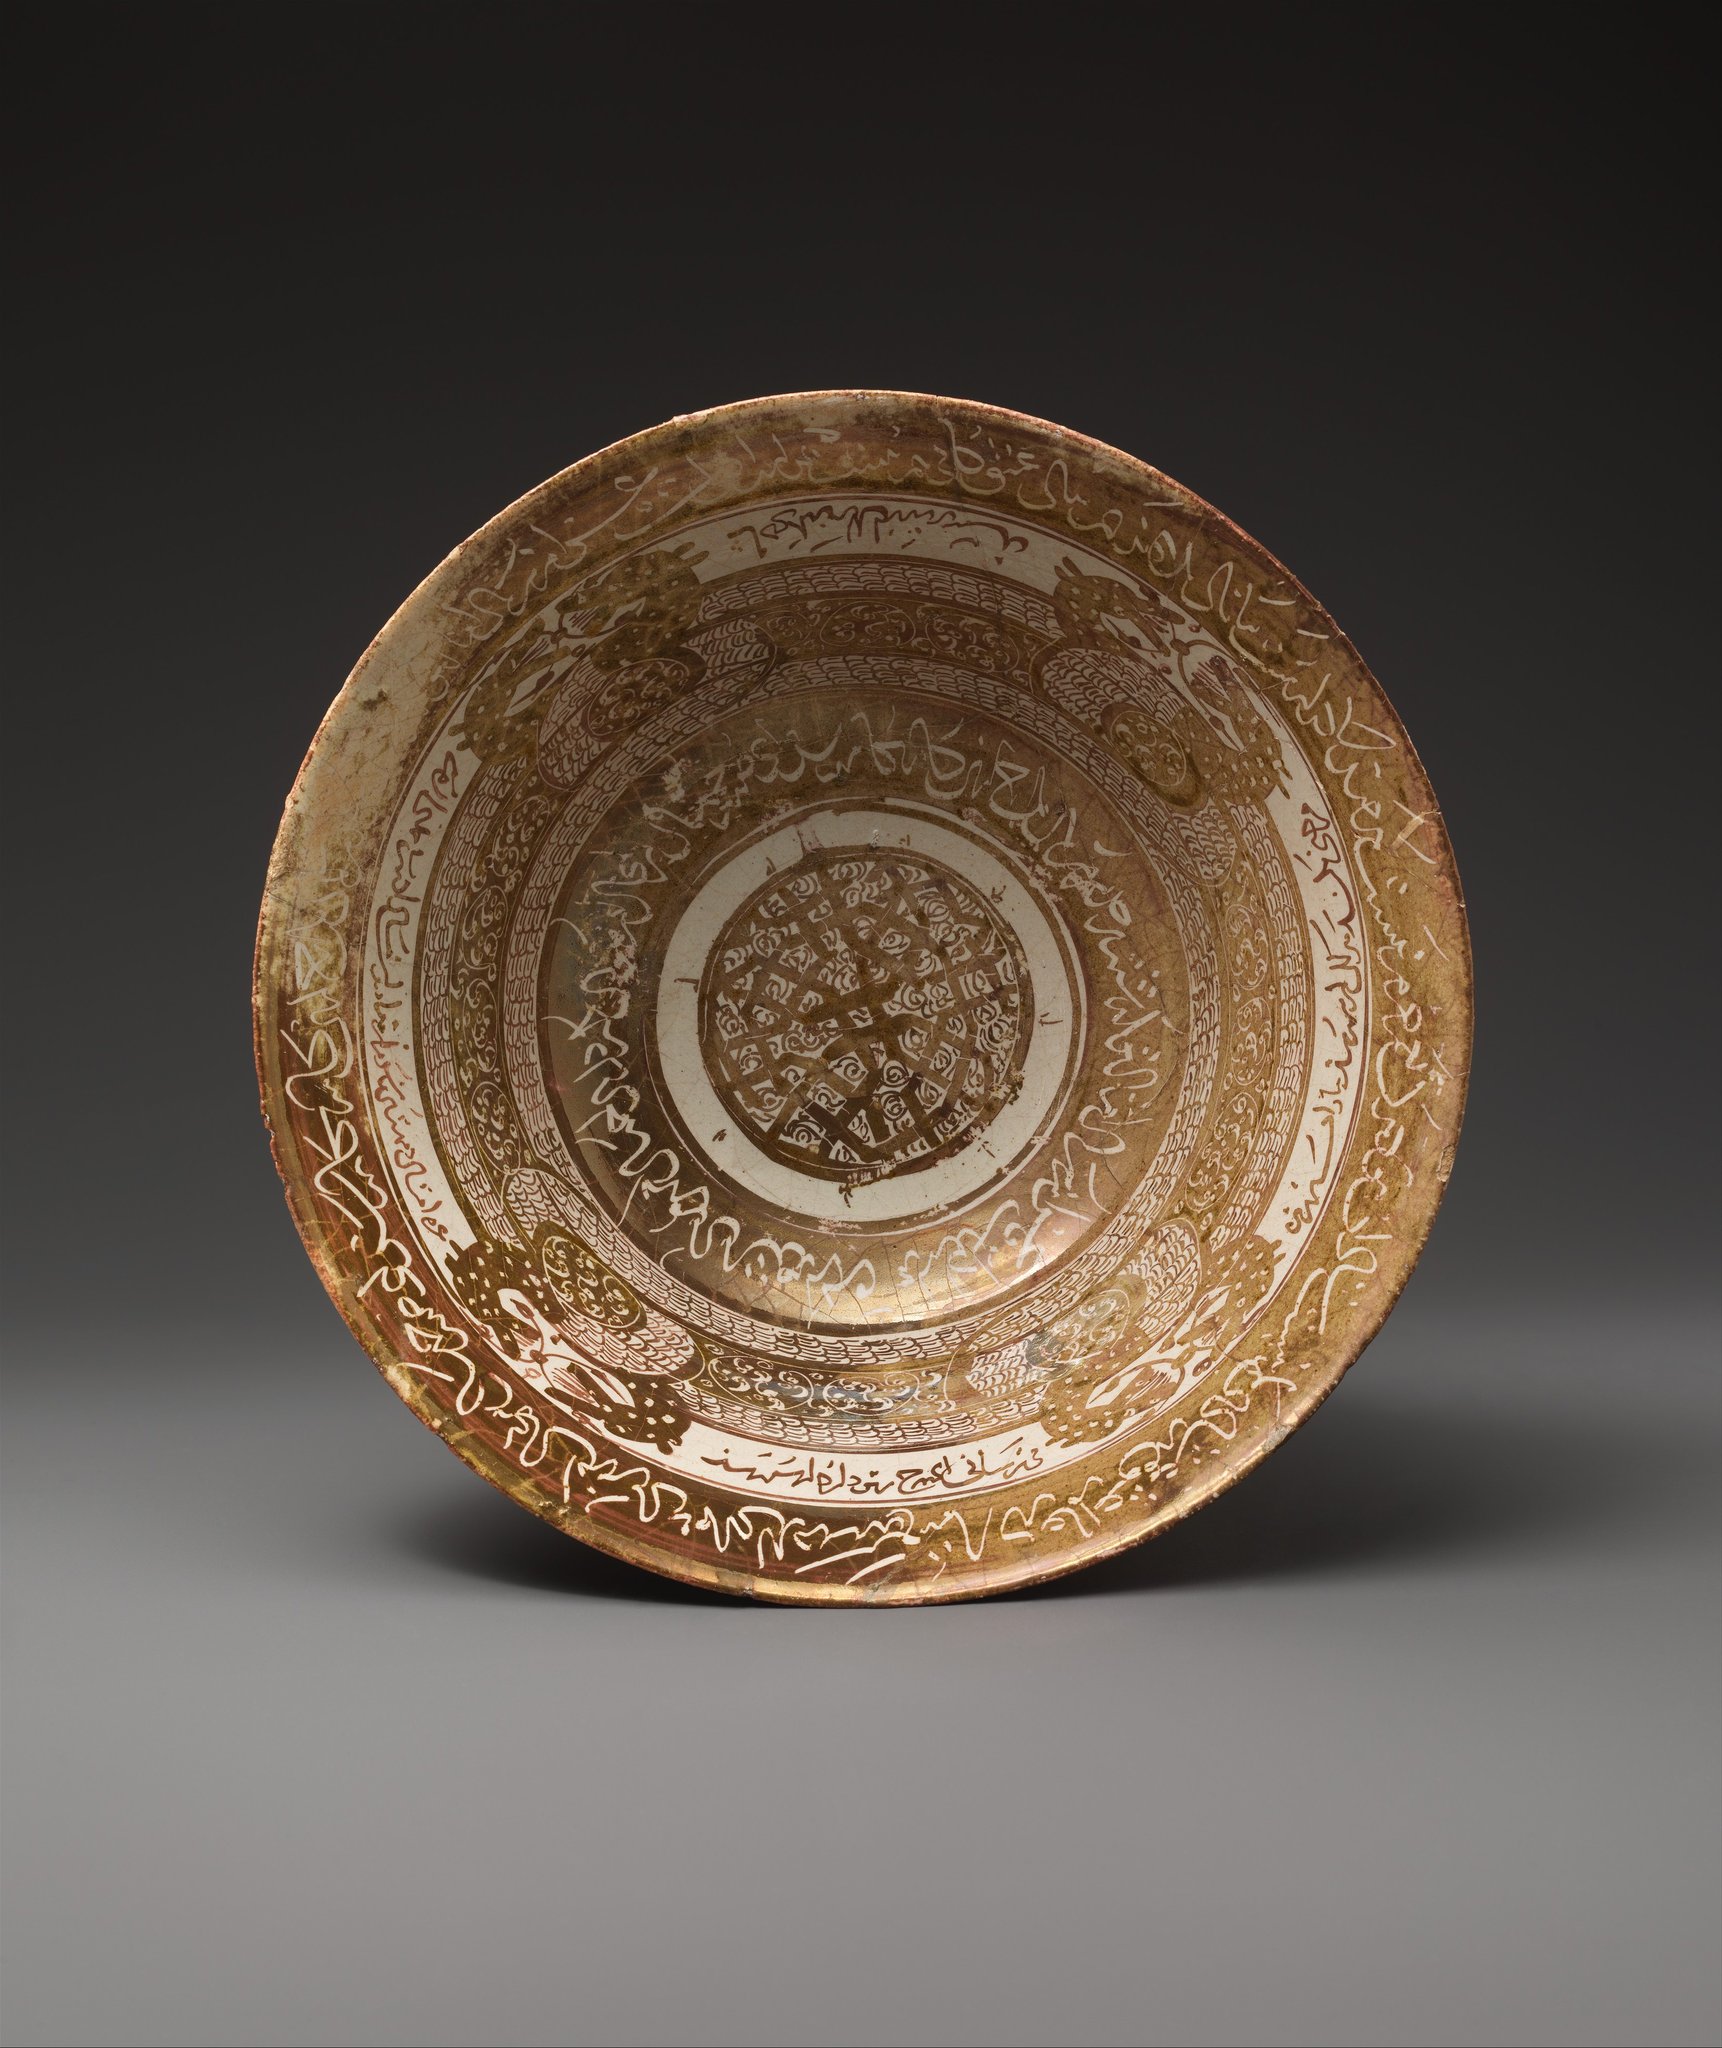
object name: bowl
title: Bowl with Dragons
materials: stonepaste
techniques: glazing, luster painting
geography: iran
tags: dragons